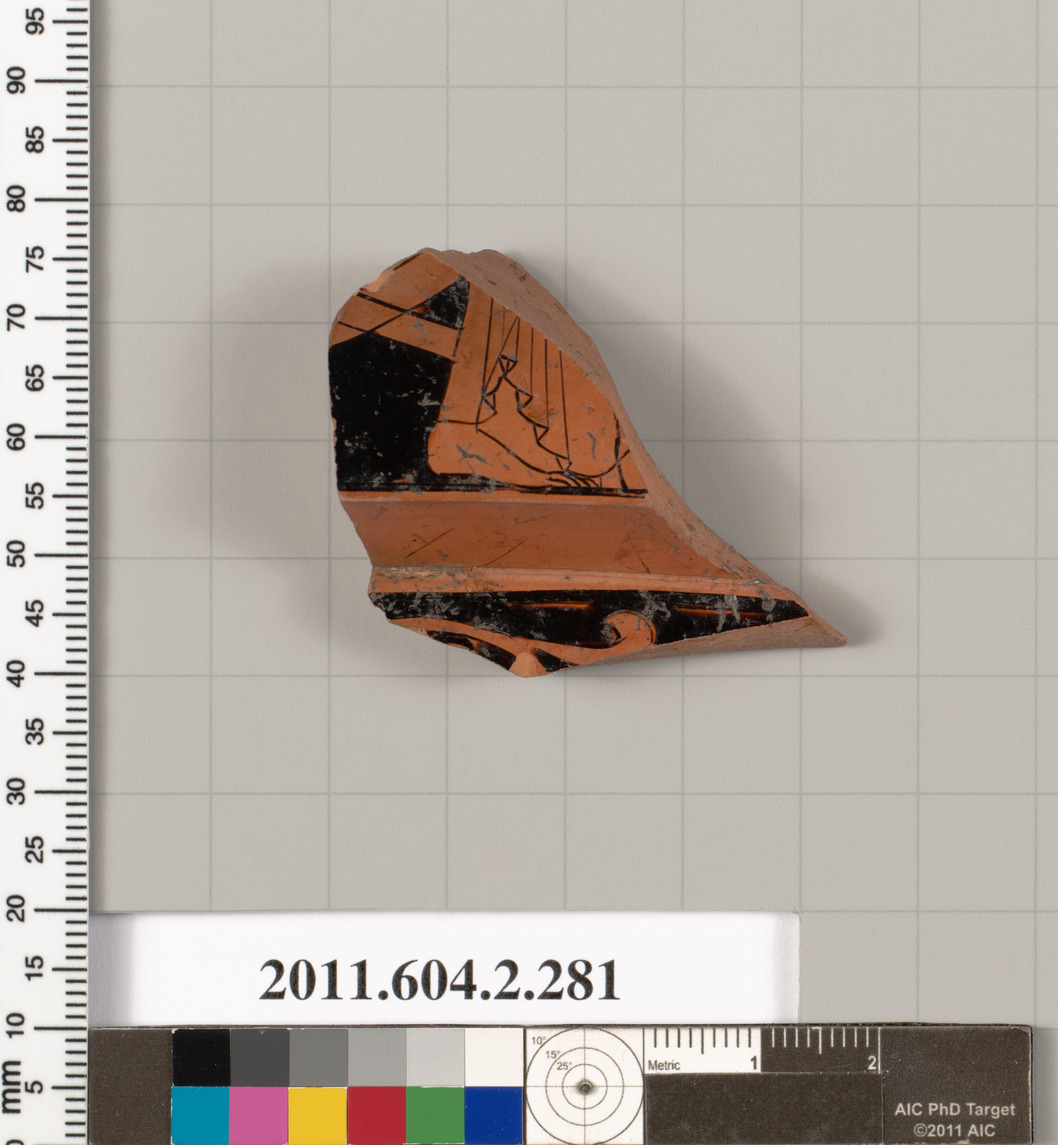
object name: volute krater fragment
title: Terracotta fragment of a volute-krater (bowl for mixing wine and water)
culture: greek, attic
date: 490-480 BCE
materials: terracotta